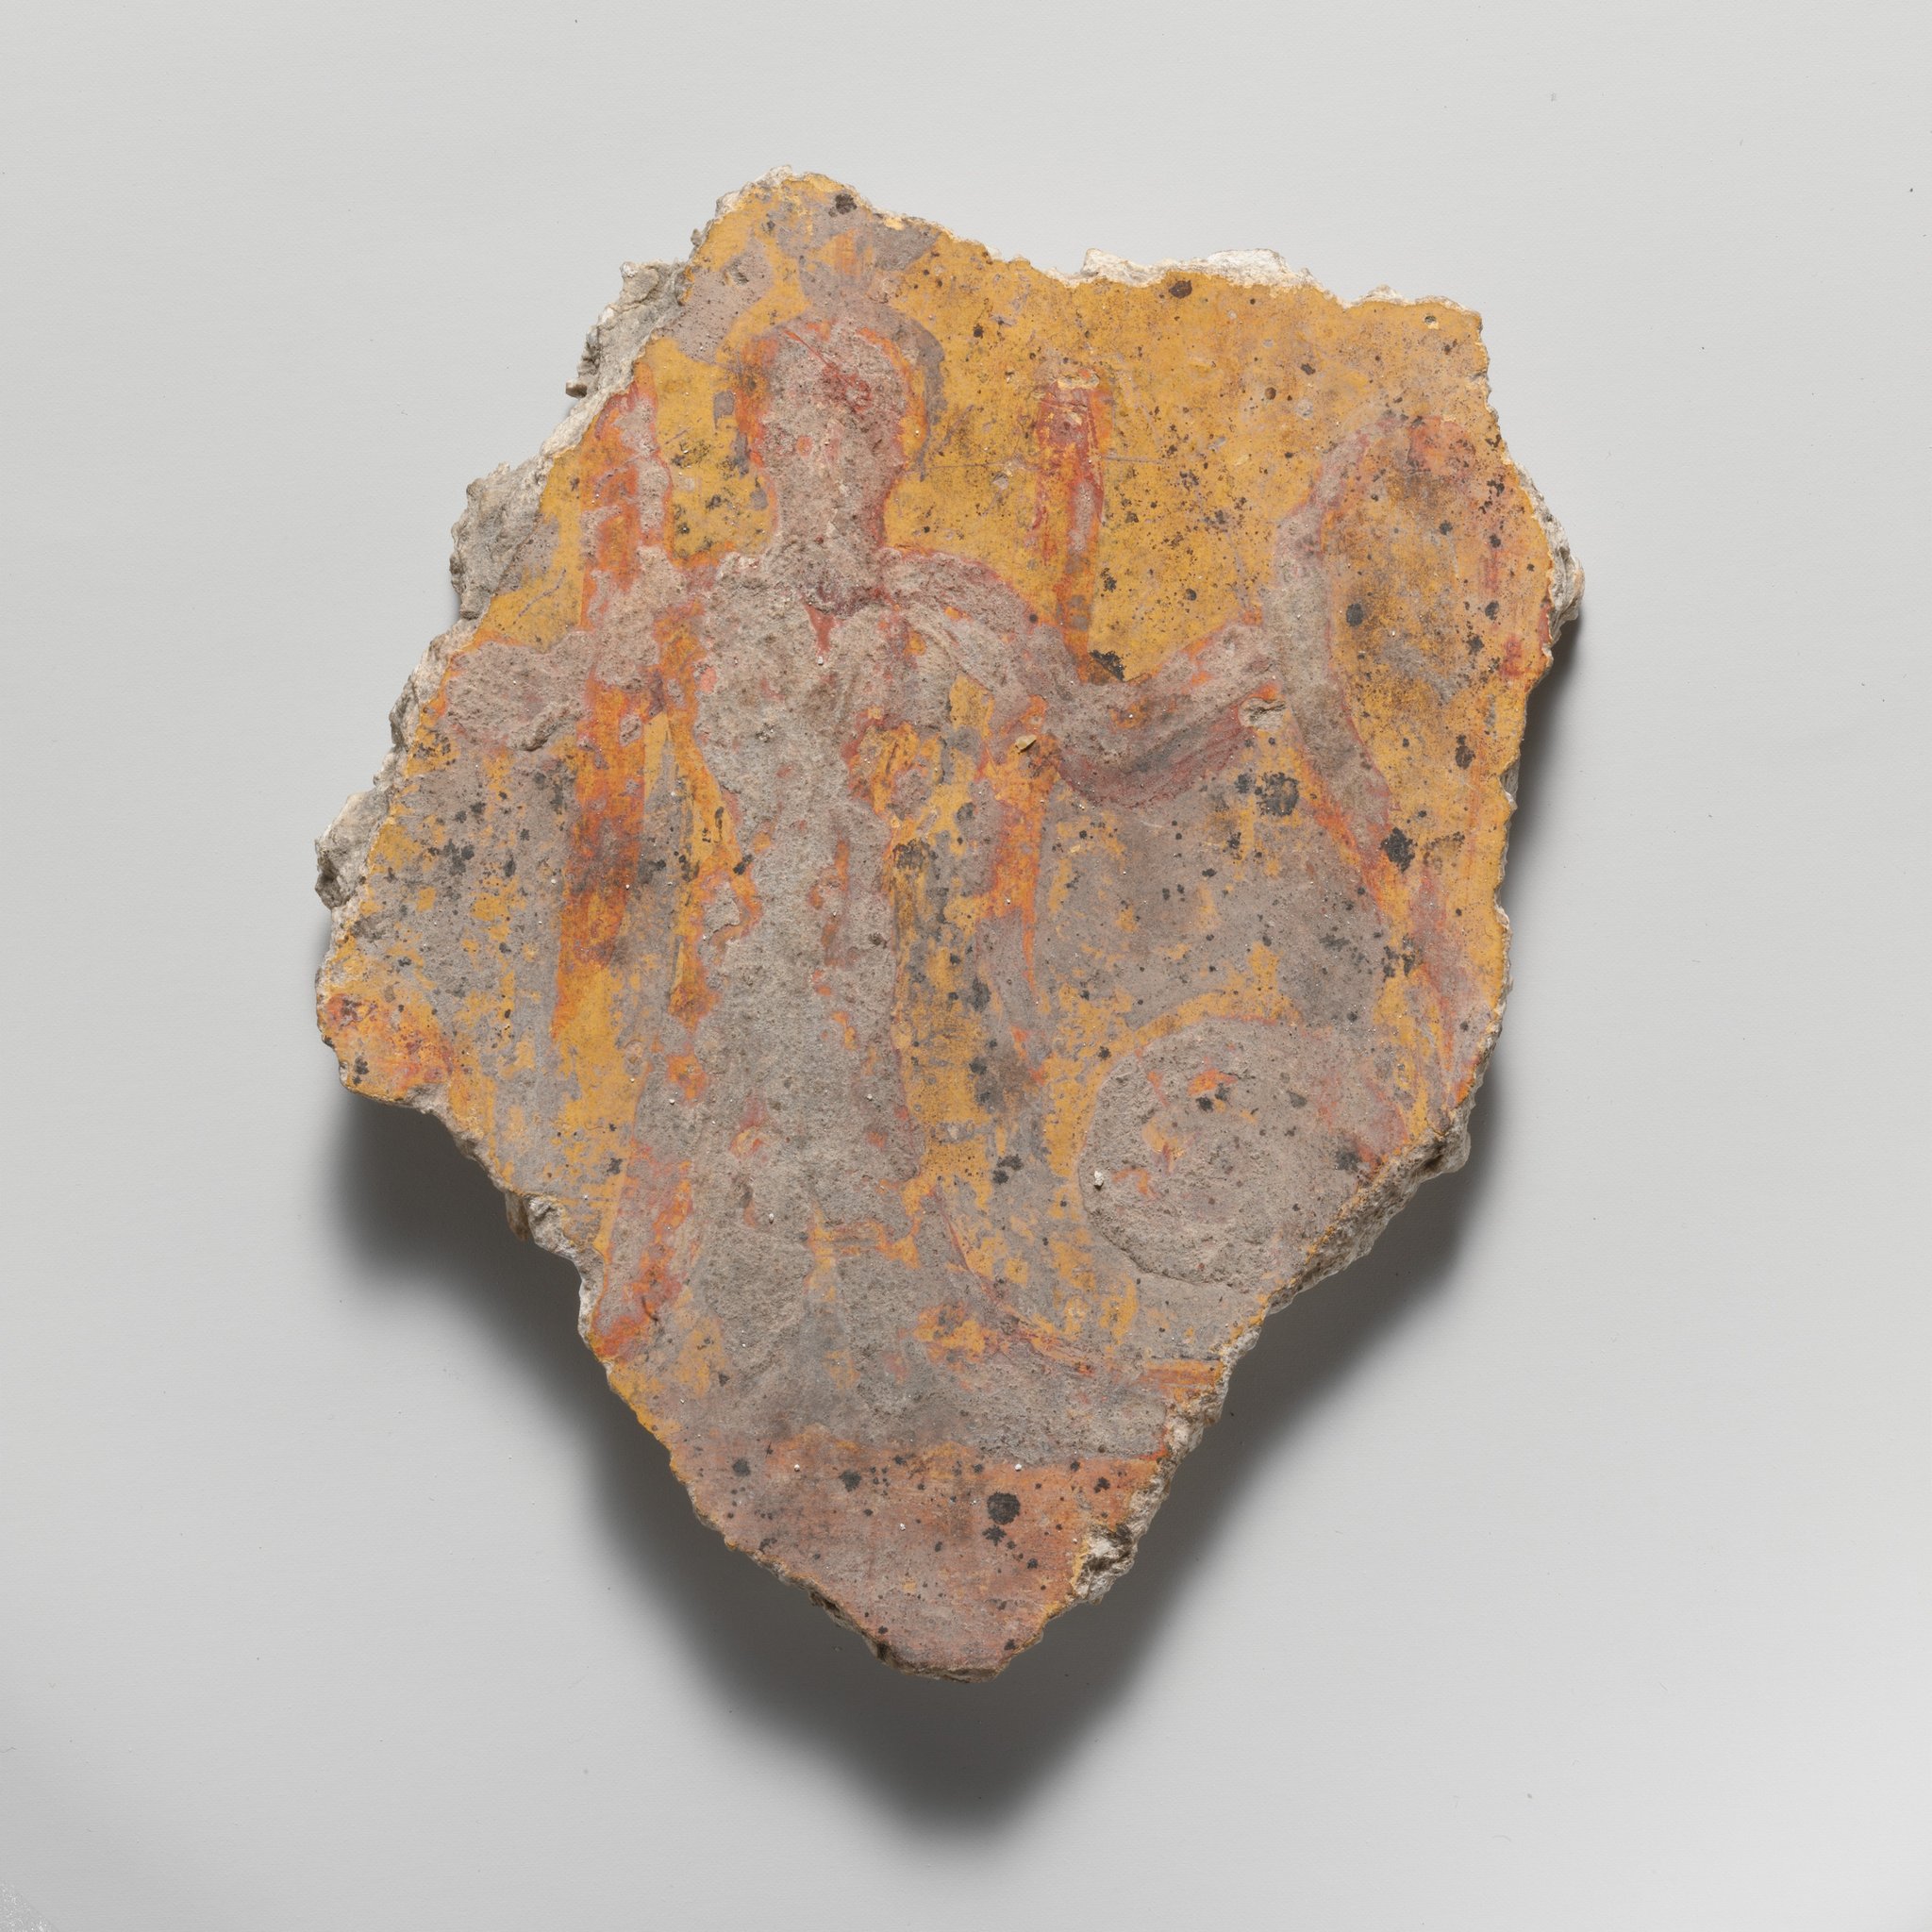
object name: wall painting fragment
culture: roman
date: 1-100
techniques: fresco